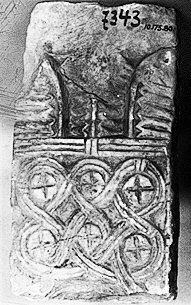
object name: pilaster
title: Possibly a Pilaster with a Pattern of Guilloche and Palm Leaves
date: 501-700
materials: stone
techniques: carving, relief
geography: egypt